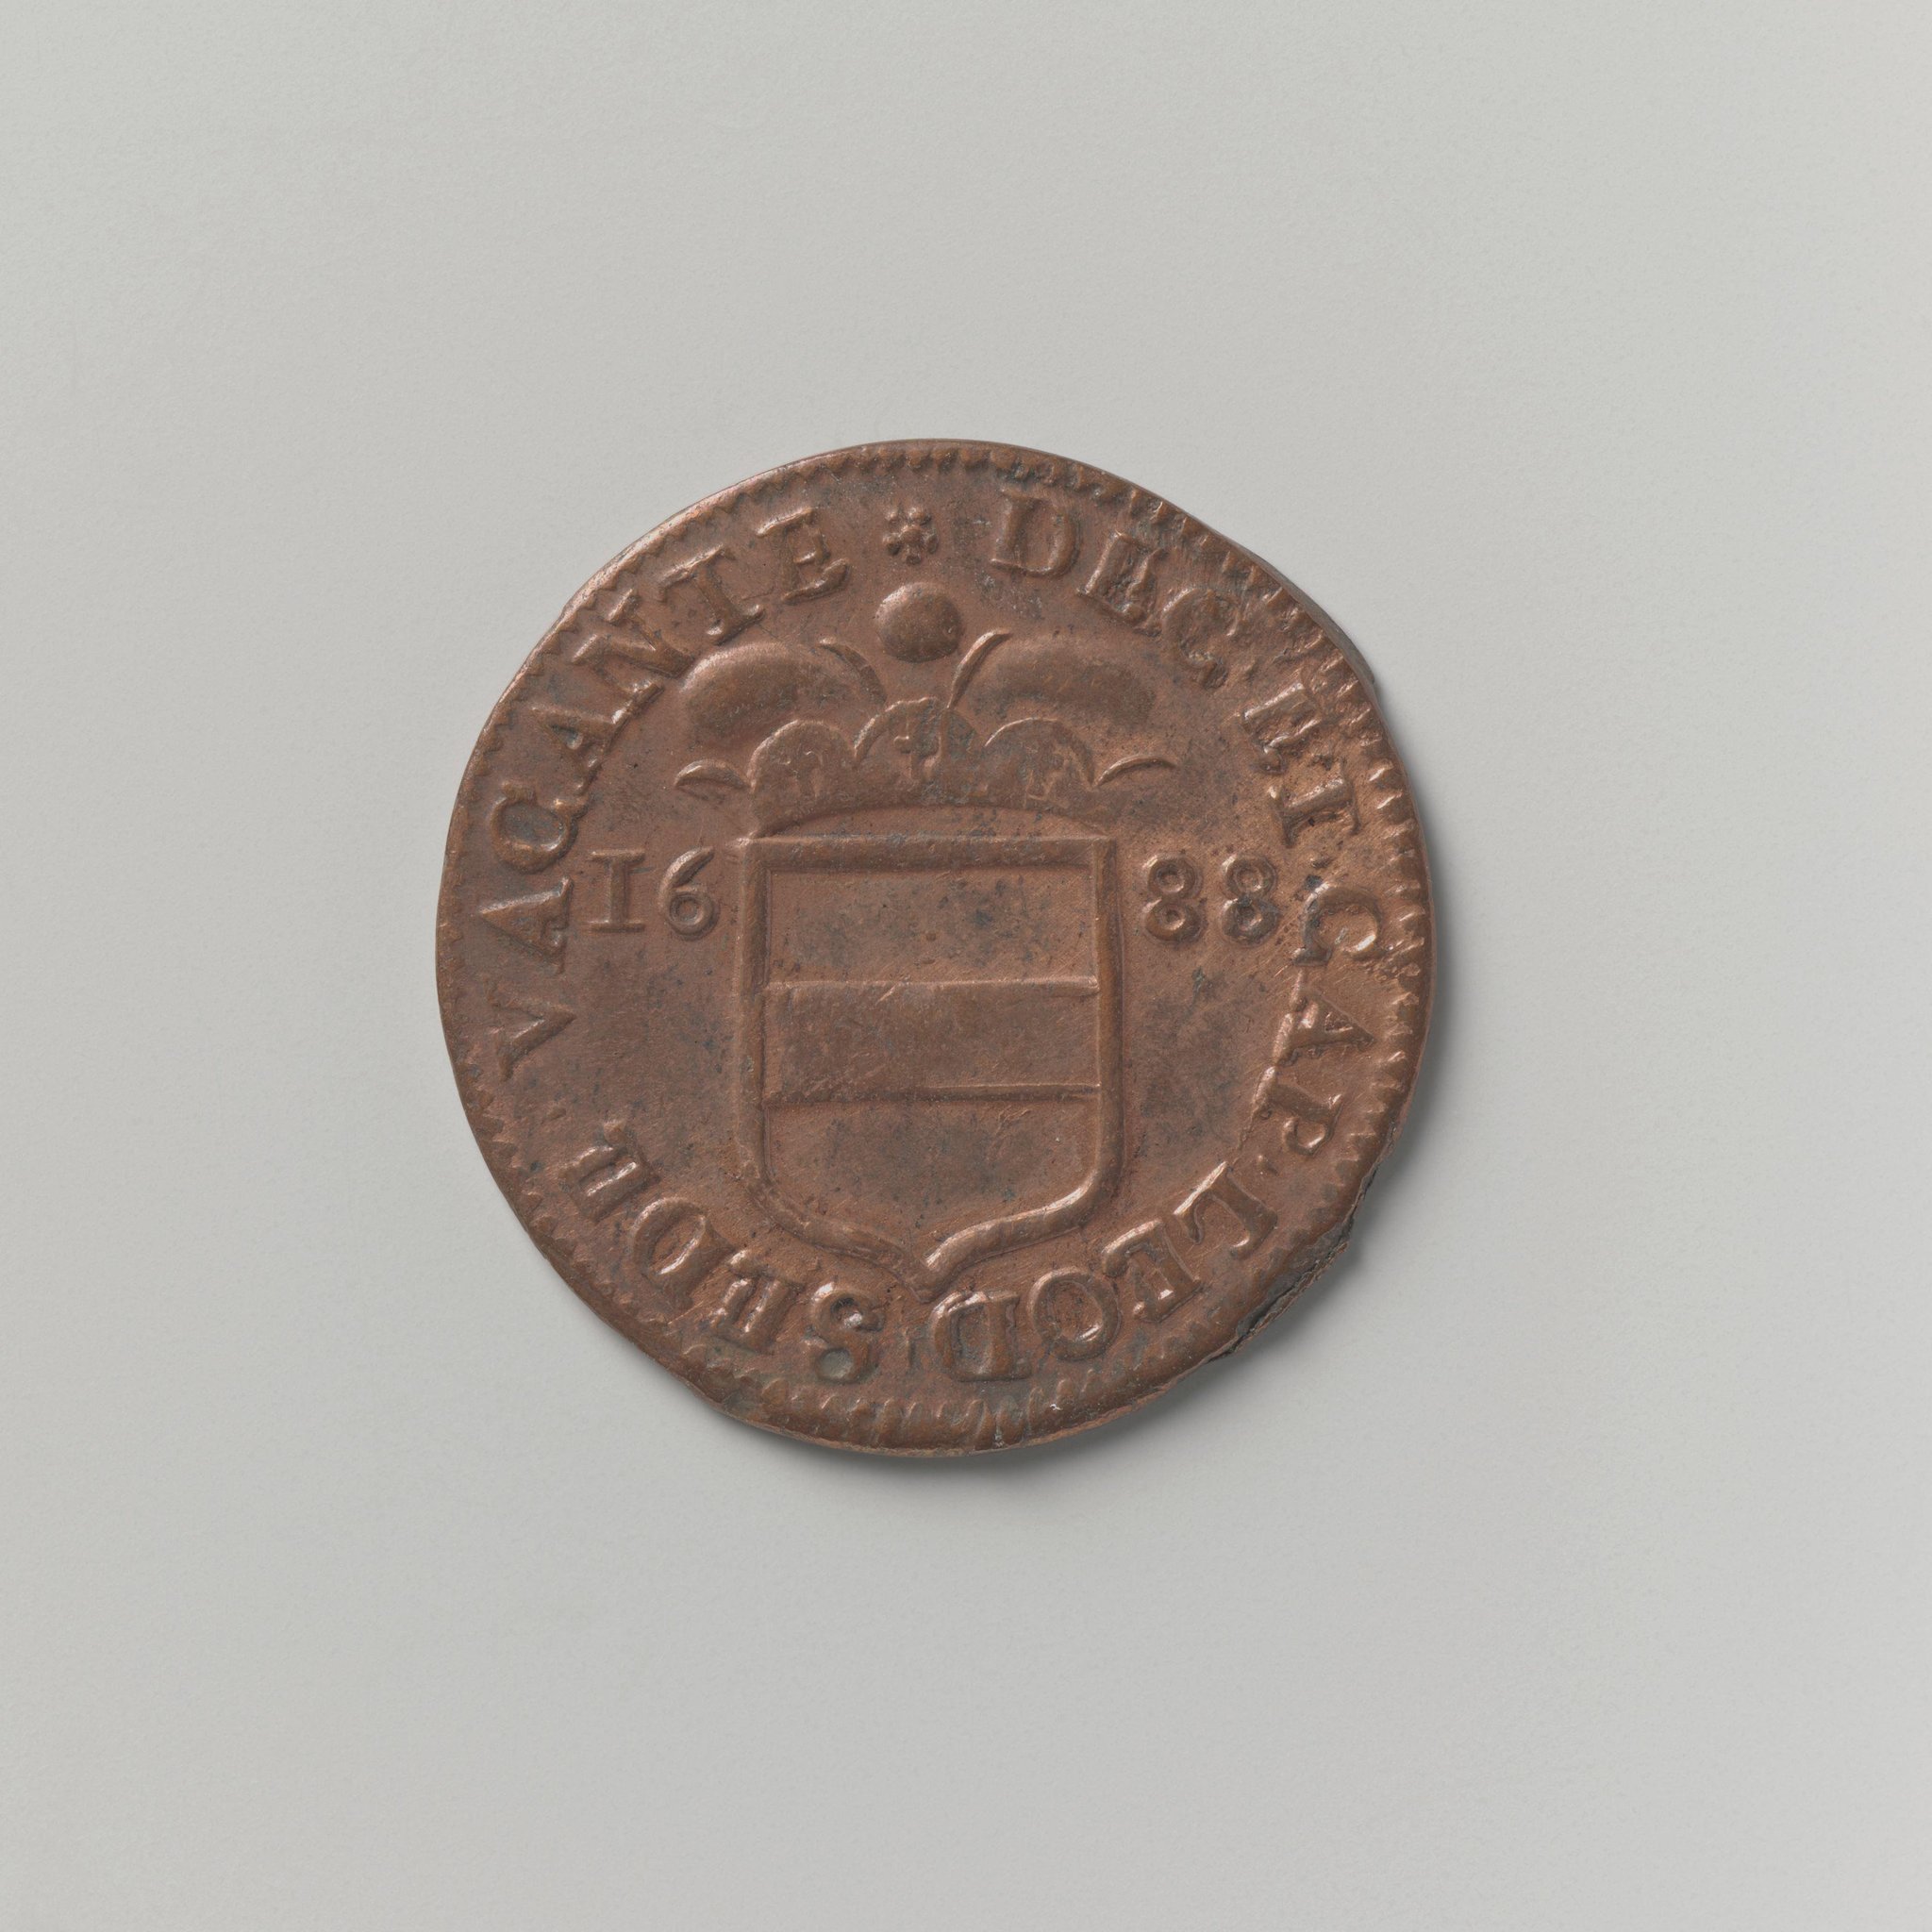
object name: coin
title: Oord uit bisdom Luik tijdens Sede Vacante, 1688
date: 1688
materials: copper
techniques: striking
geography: liège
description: Koperen munt. Voorzijde: portret van de heilige Lambertus naar links. Keerzijde: tussen jaartal gekroond wapenschild.